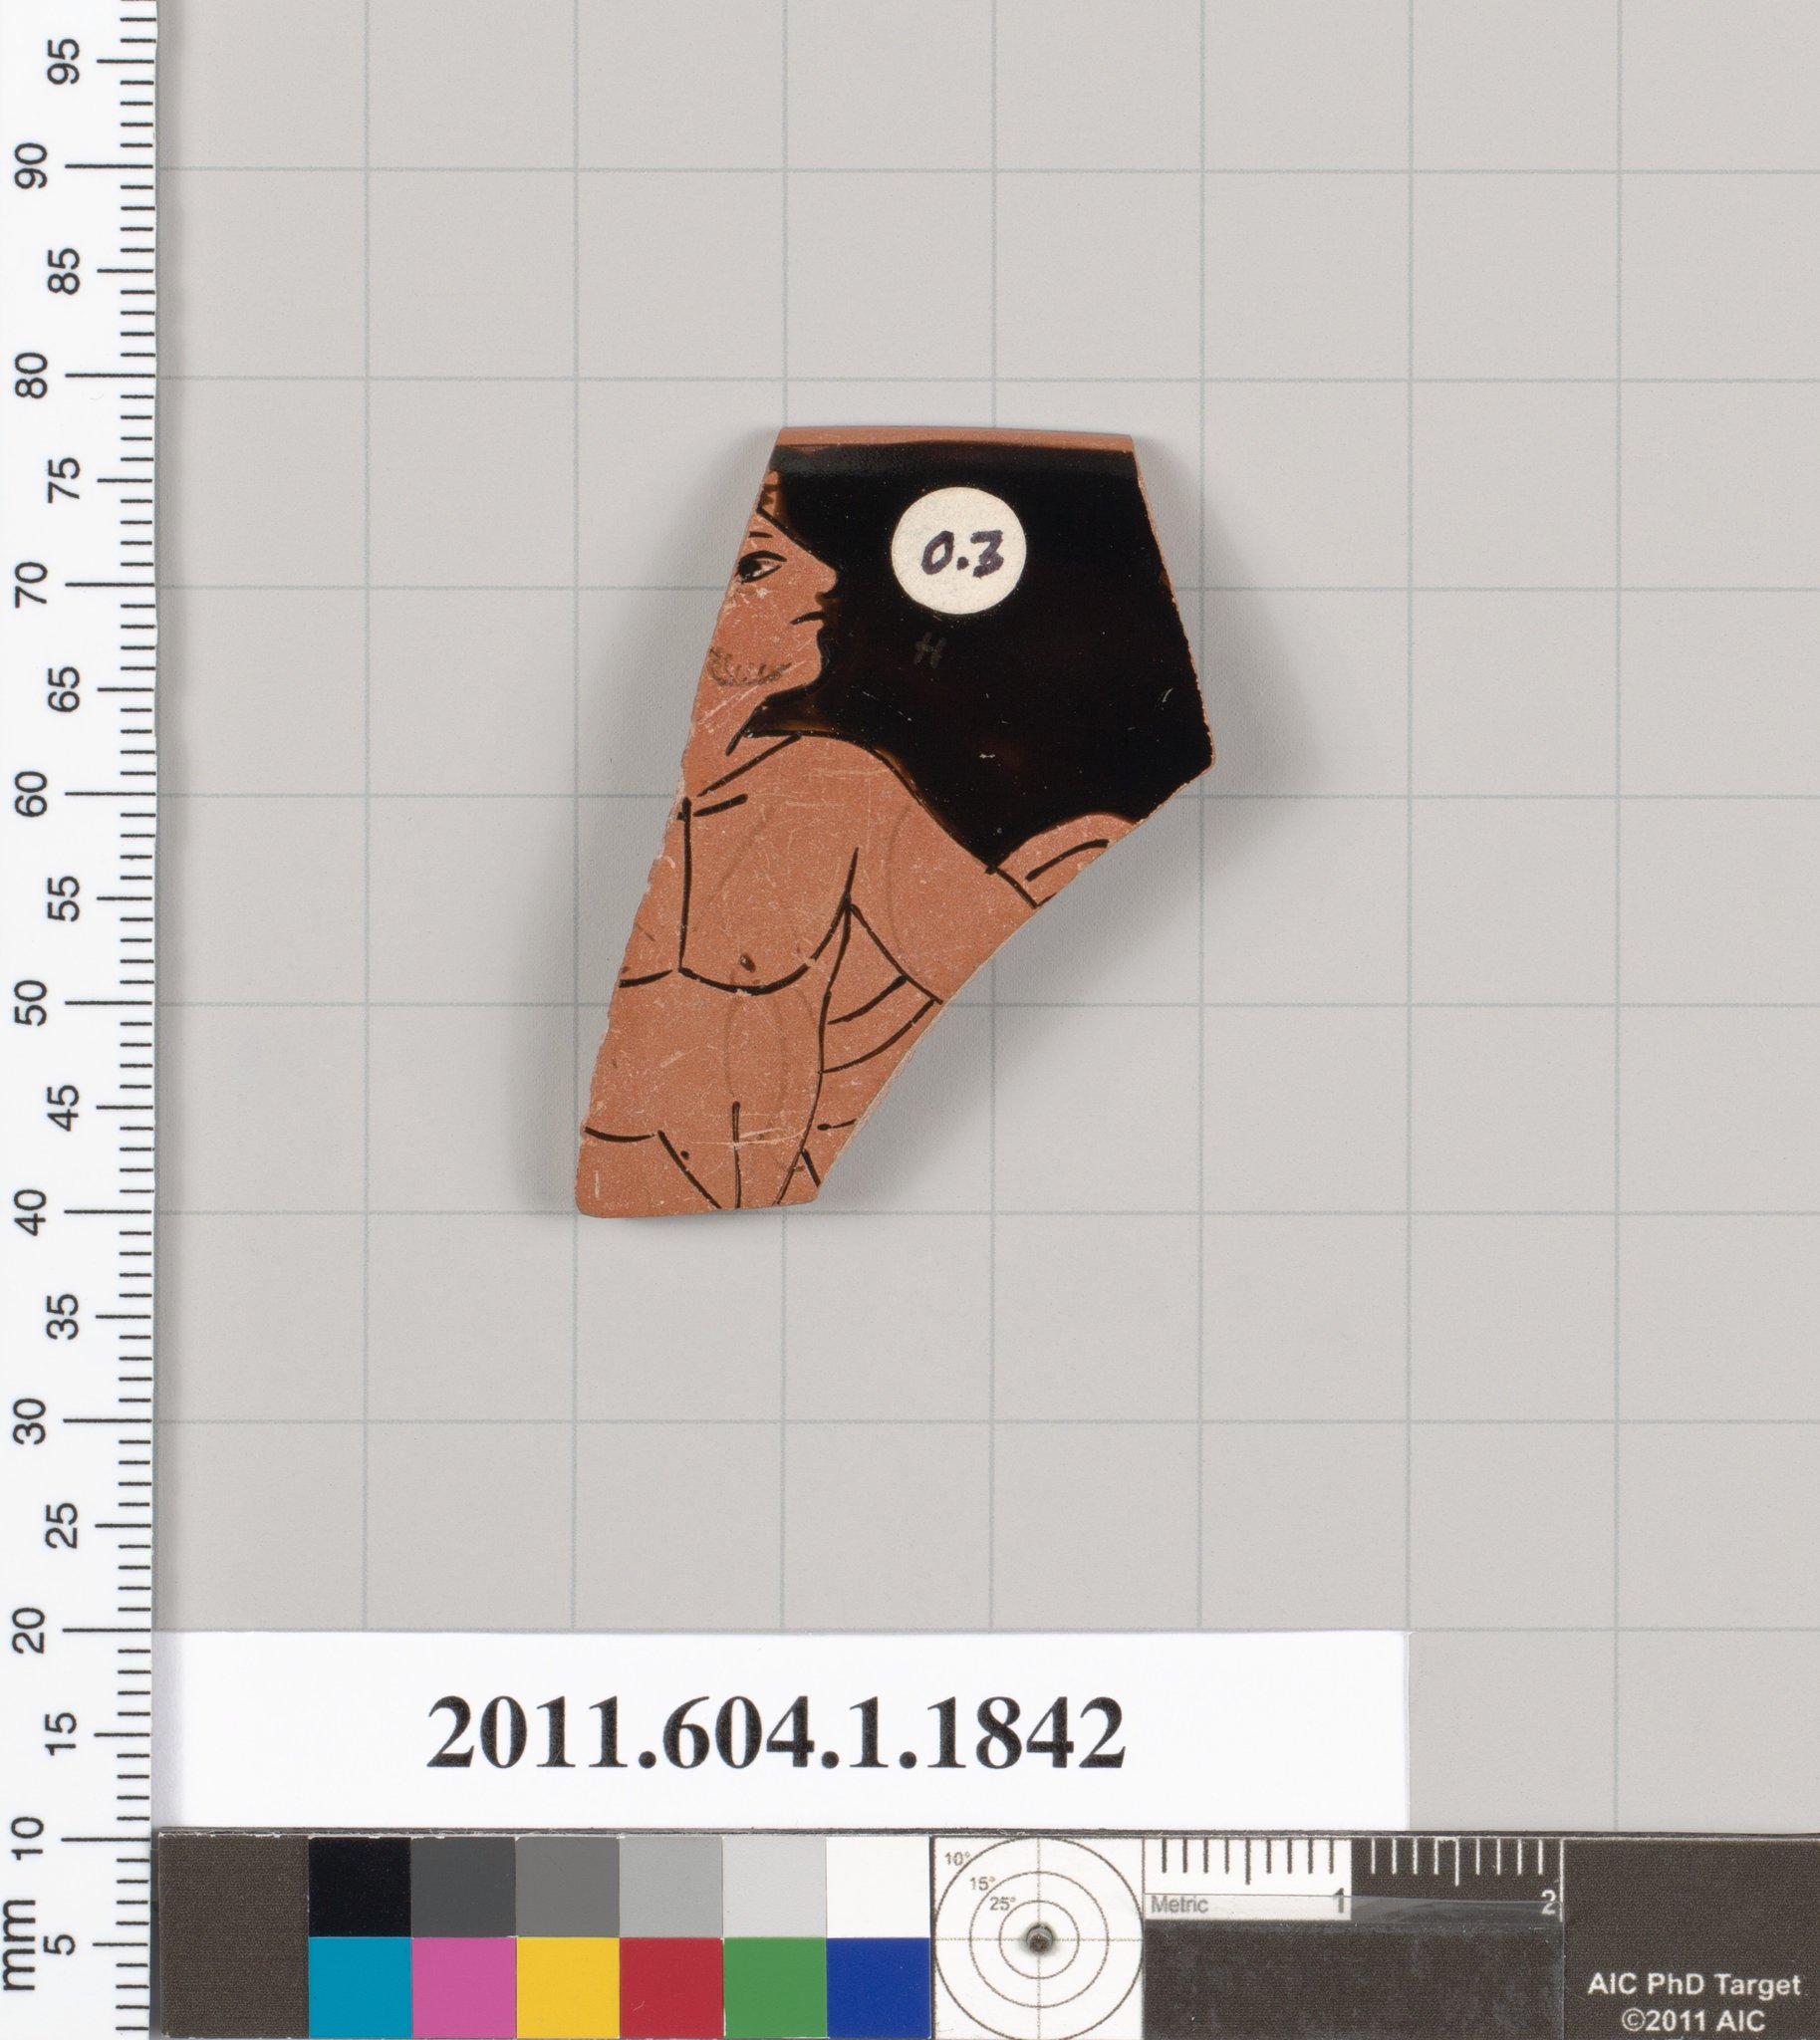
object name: kylix fragment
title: Terracotta rim fragment of a kylix (drinking cup)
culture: greek, attic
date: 534-501 BCE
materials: terracotta